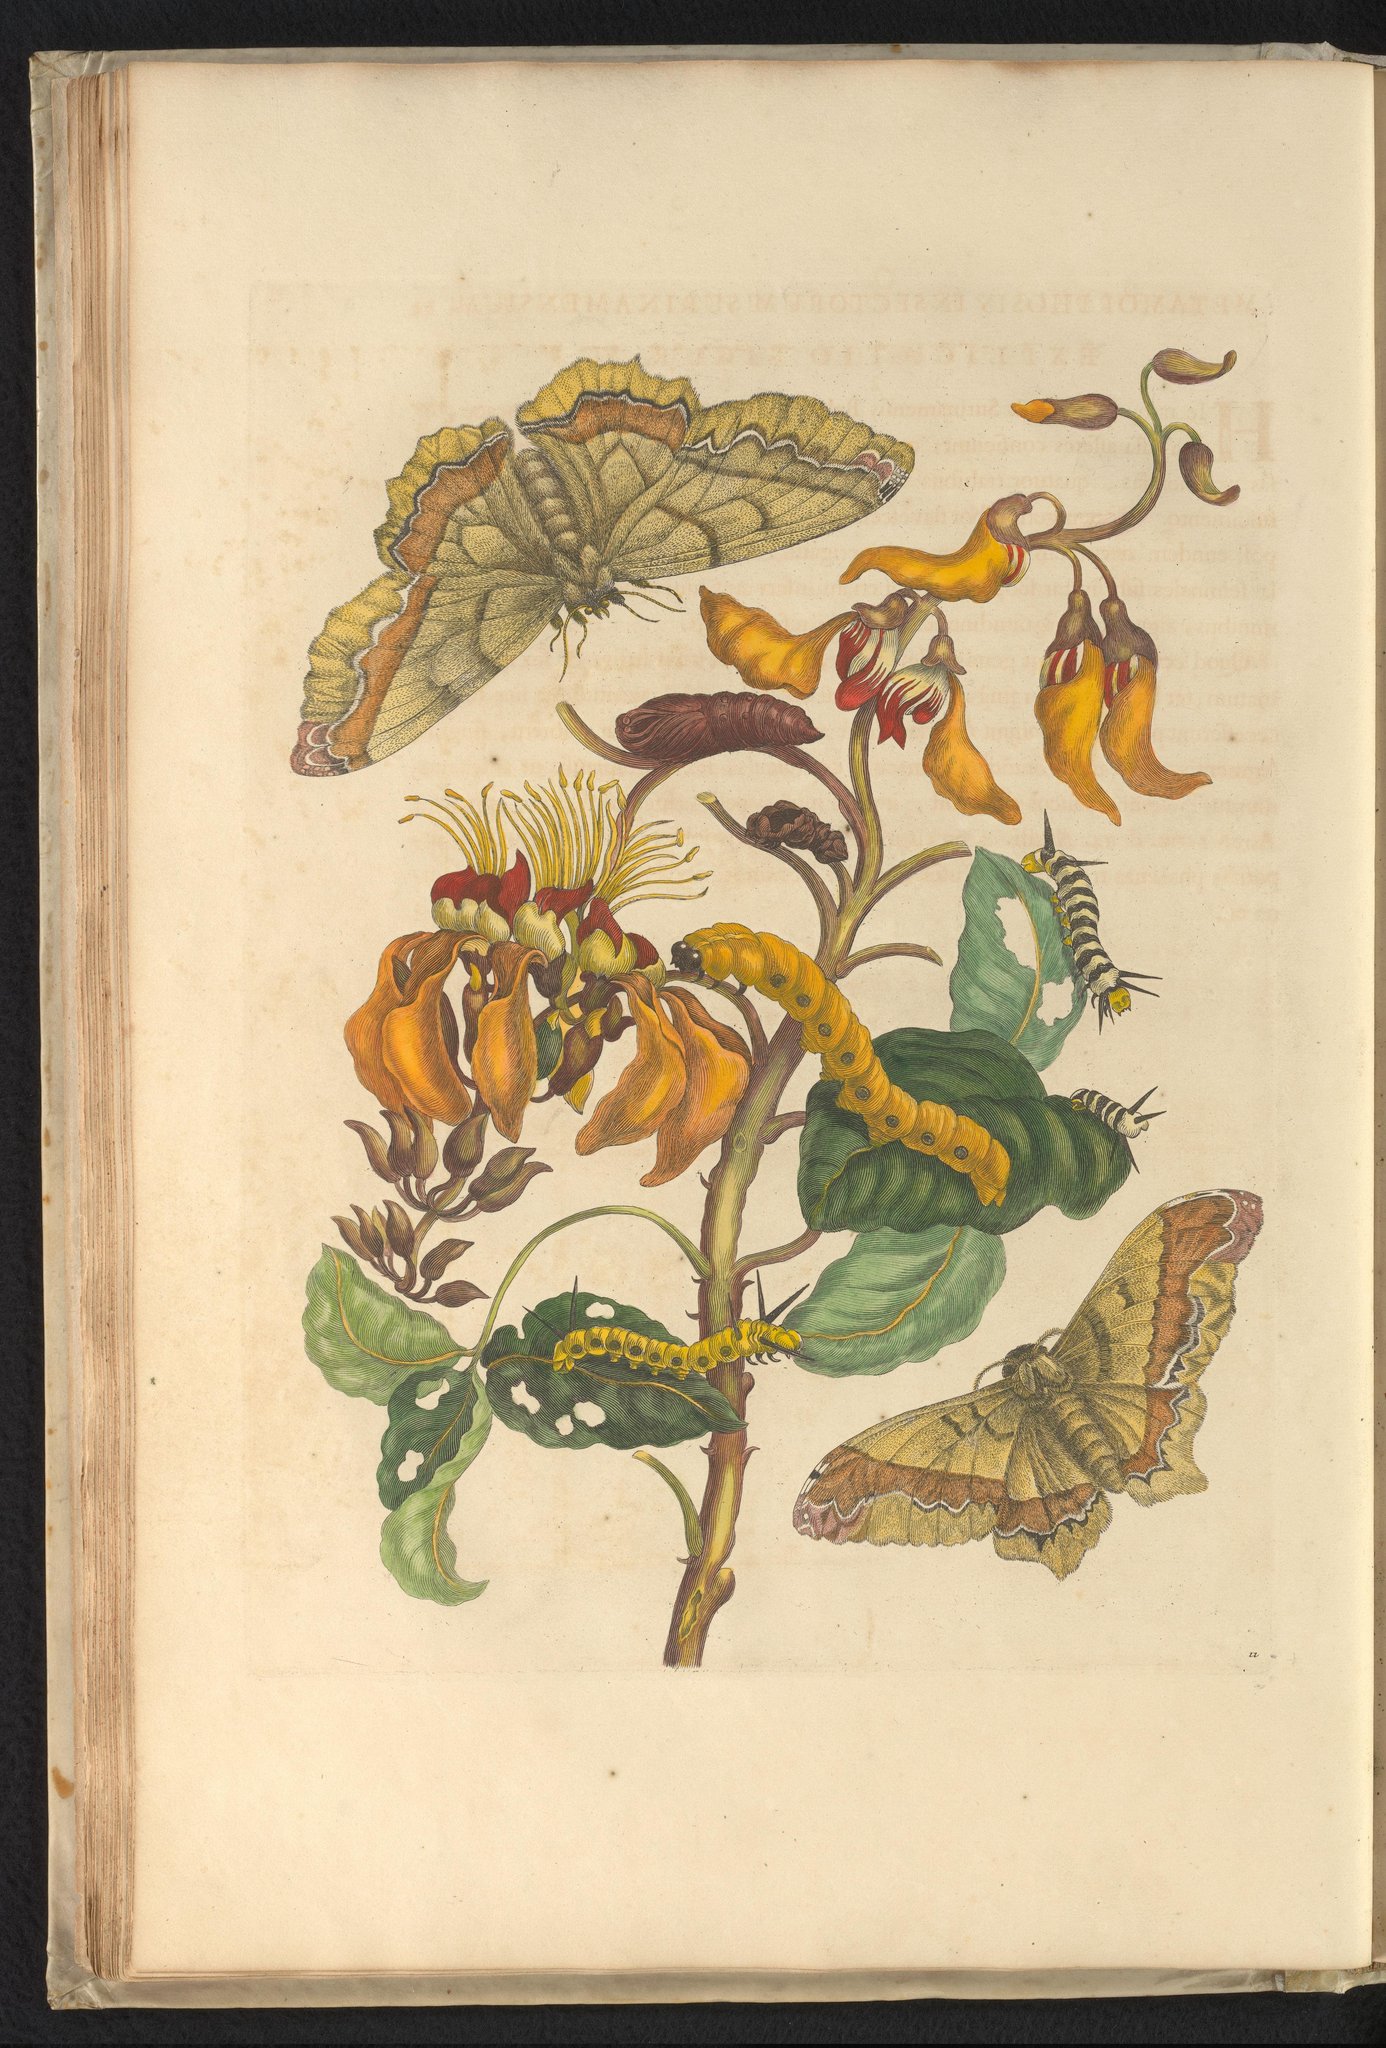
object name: print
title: Koffiemama (Erythrina fusca) met vlinders, rupsen en pop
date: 1705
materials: paper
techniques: etching, hand coloring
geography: amsterdam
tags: trees, insects: pupa, insects: butterfly, insects: caterpillar, suriname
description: Rechtsonder genummerd: 11. Prent maakt deel uit van een boek.